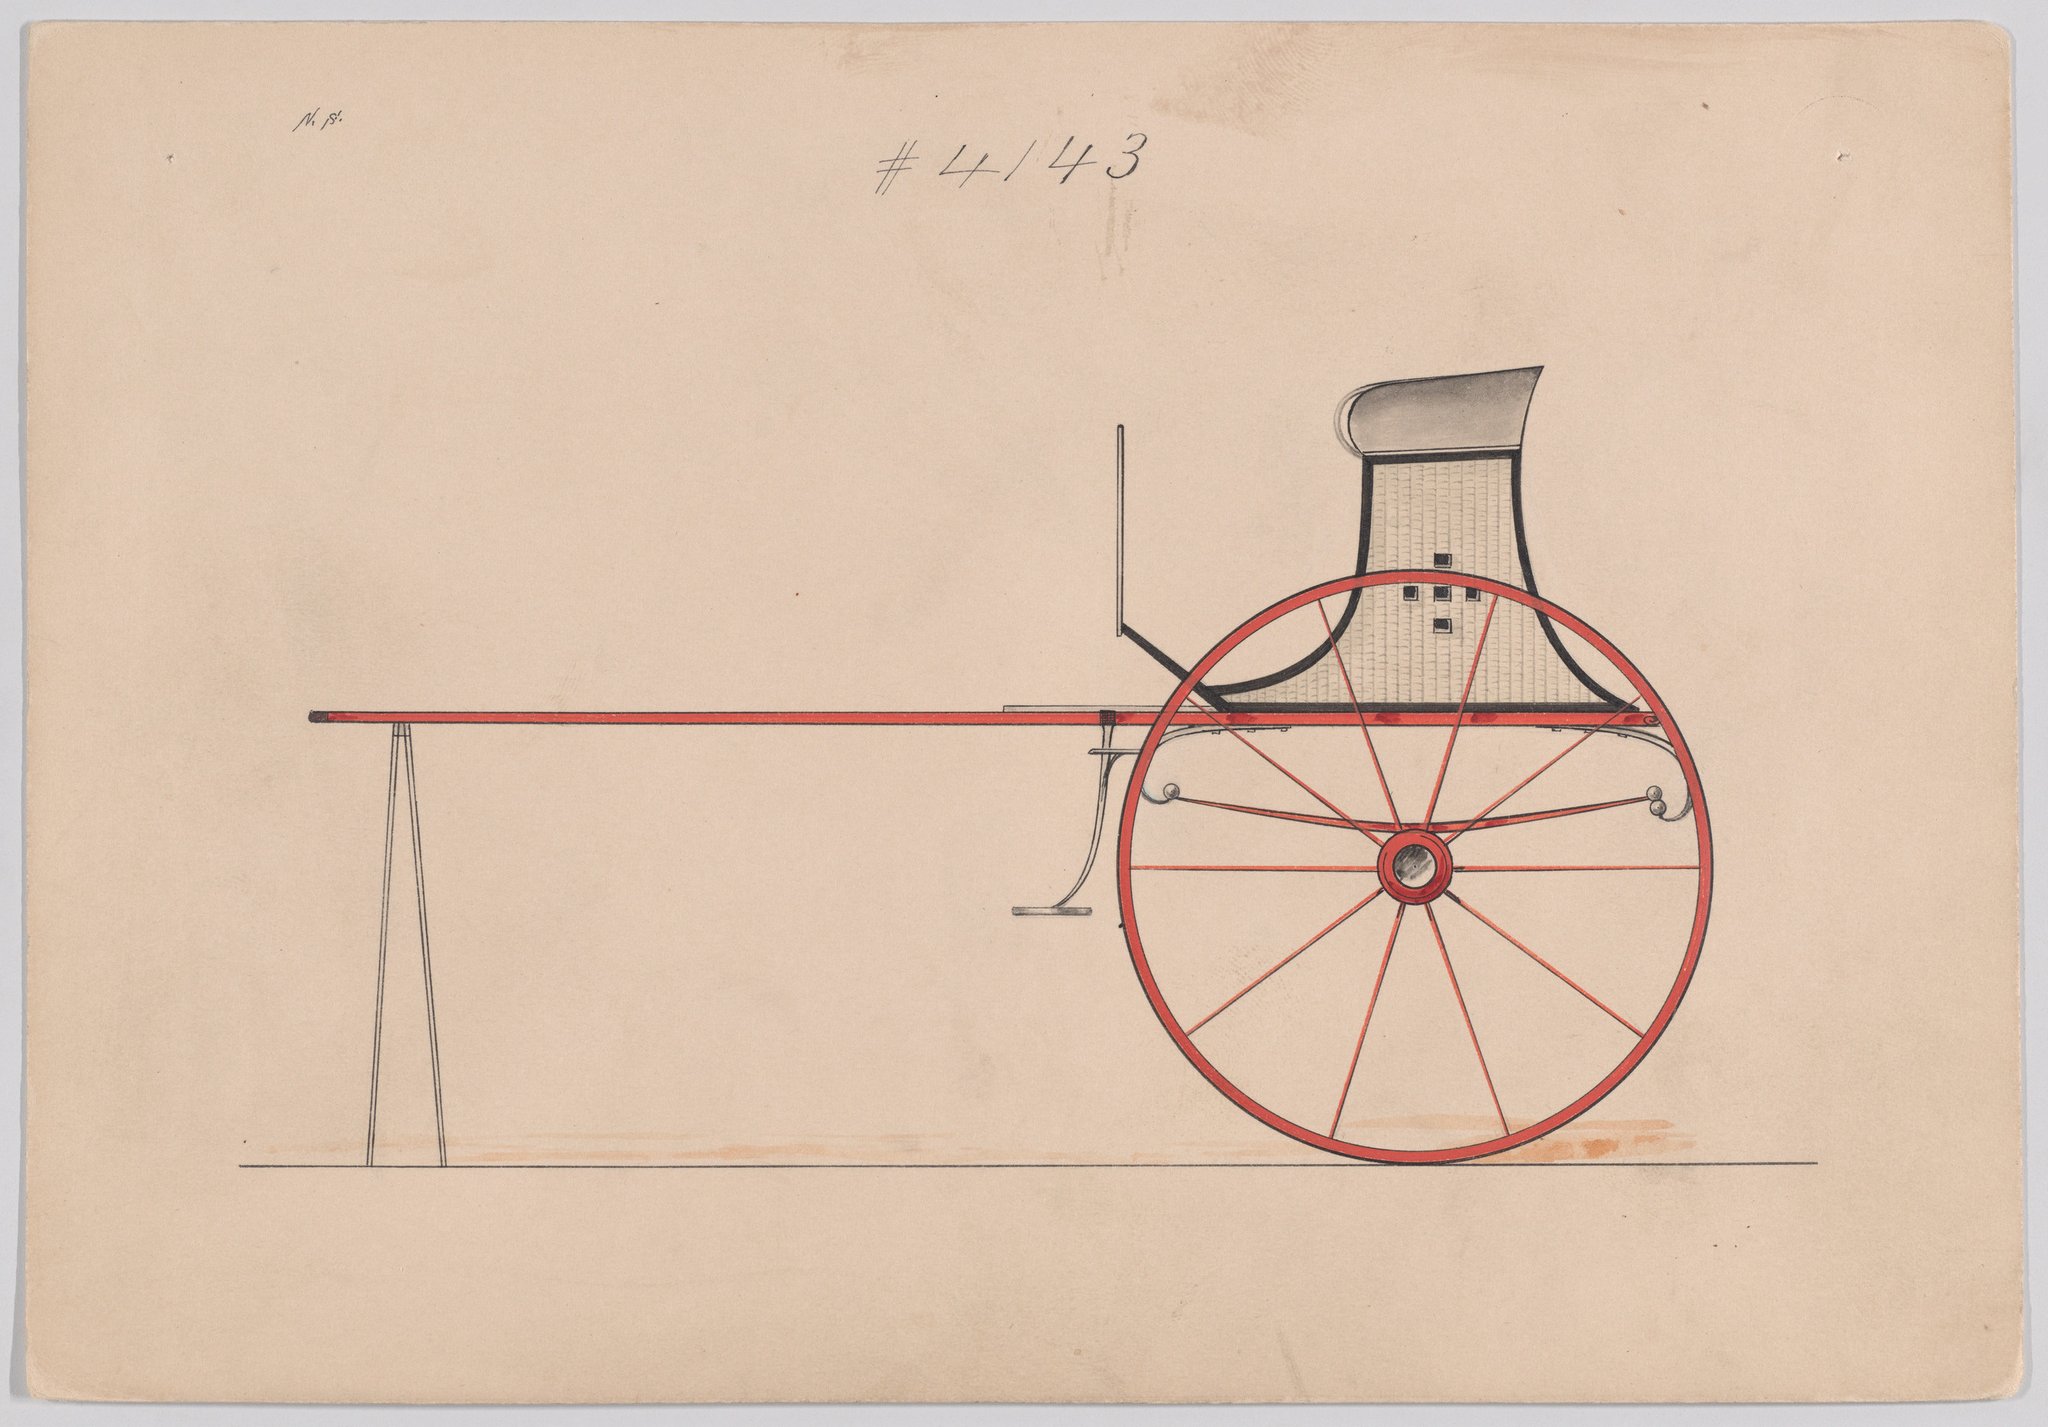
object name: drawing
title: Design for Dog Cart or 2 Wheeler, no. 4143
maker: brewster & co.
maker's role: manufacturer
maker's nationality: american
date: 1891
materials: gouache, ink, watercolor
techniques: pen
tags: carriages